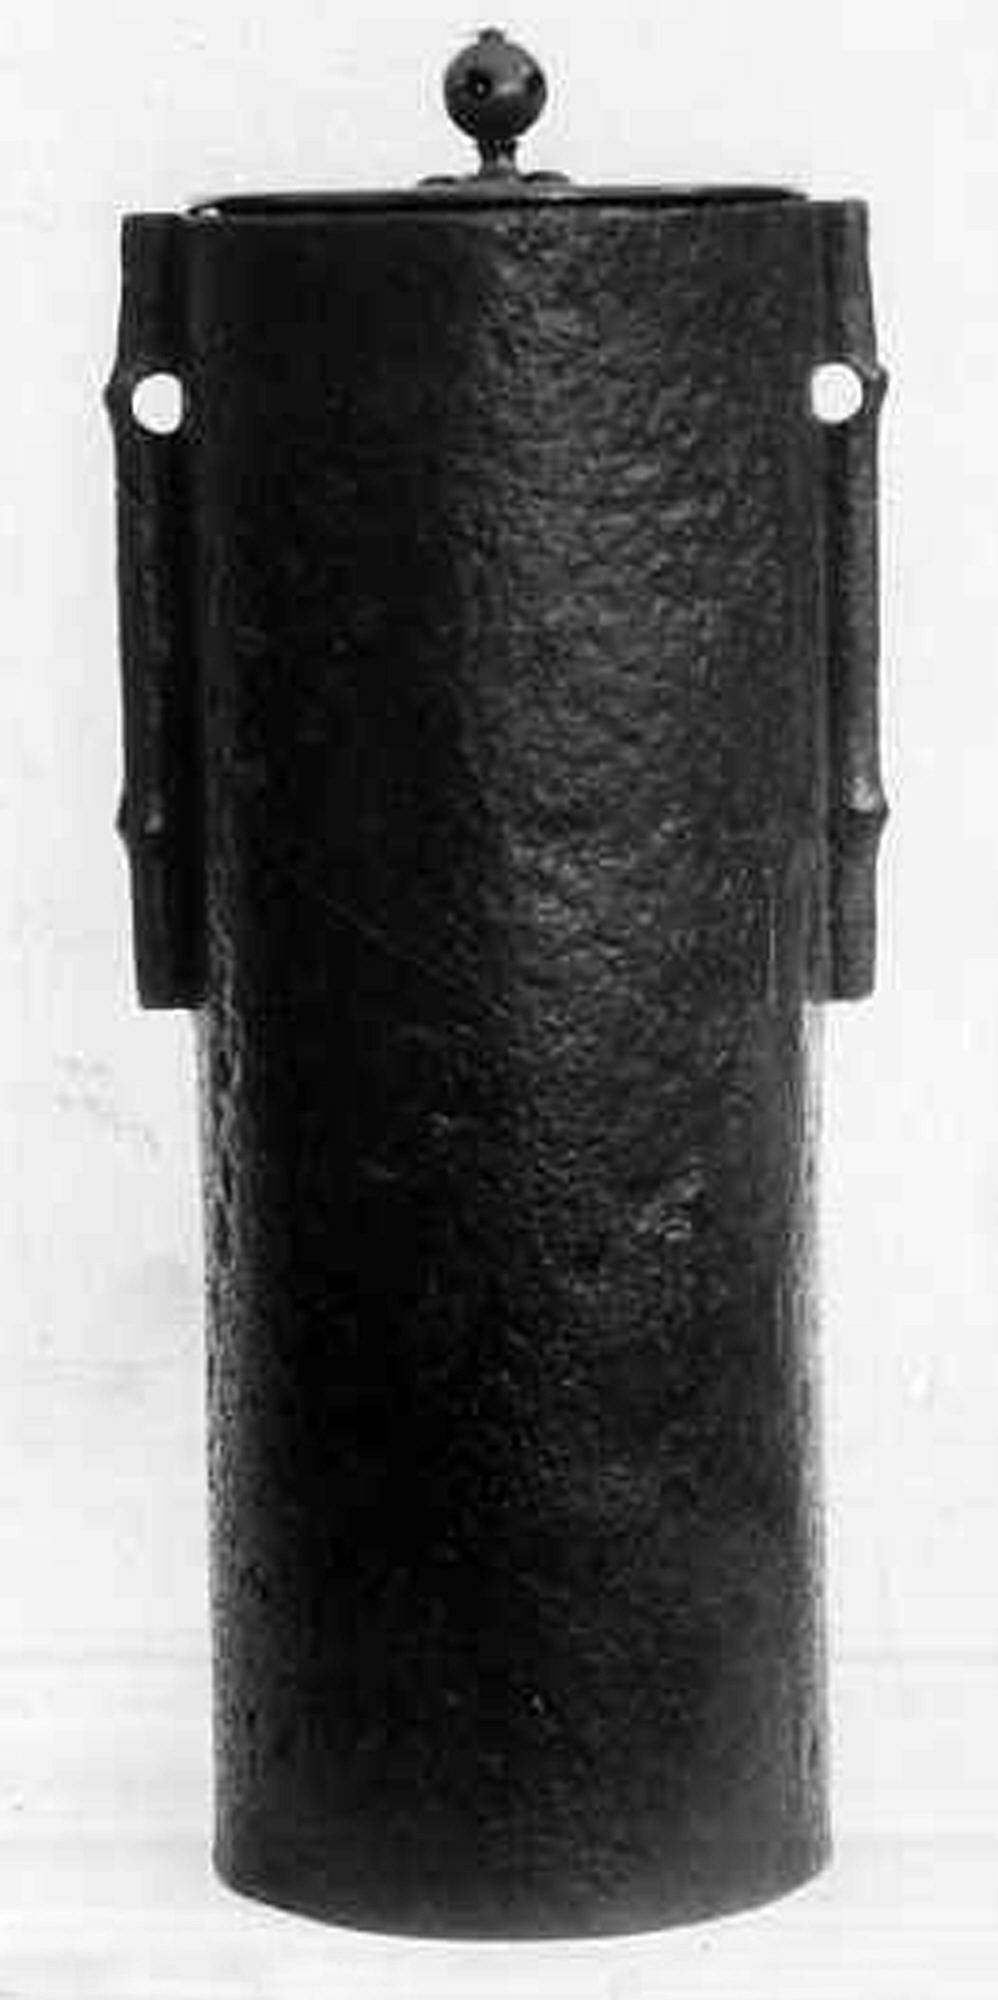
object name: water jar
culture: japanese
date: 1701-1800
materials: iron